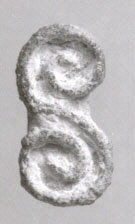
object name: stamp seal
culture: bactria-margiana archaeological complex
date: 2333-1668 BCE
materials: copper alloy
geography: bactria-margiana